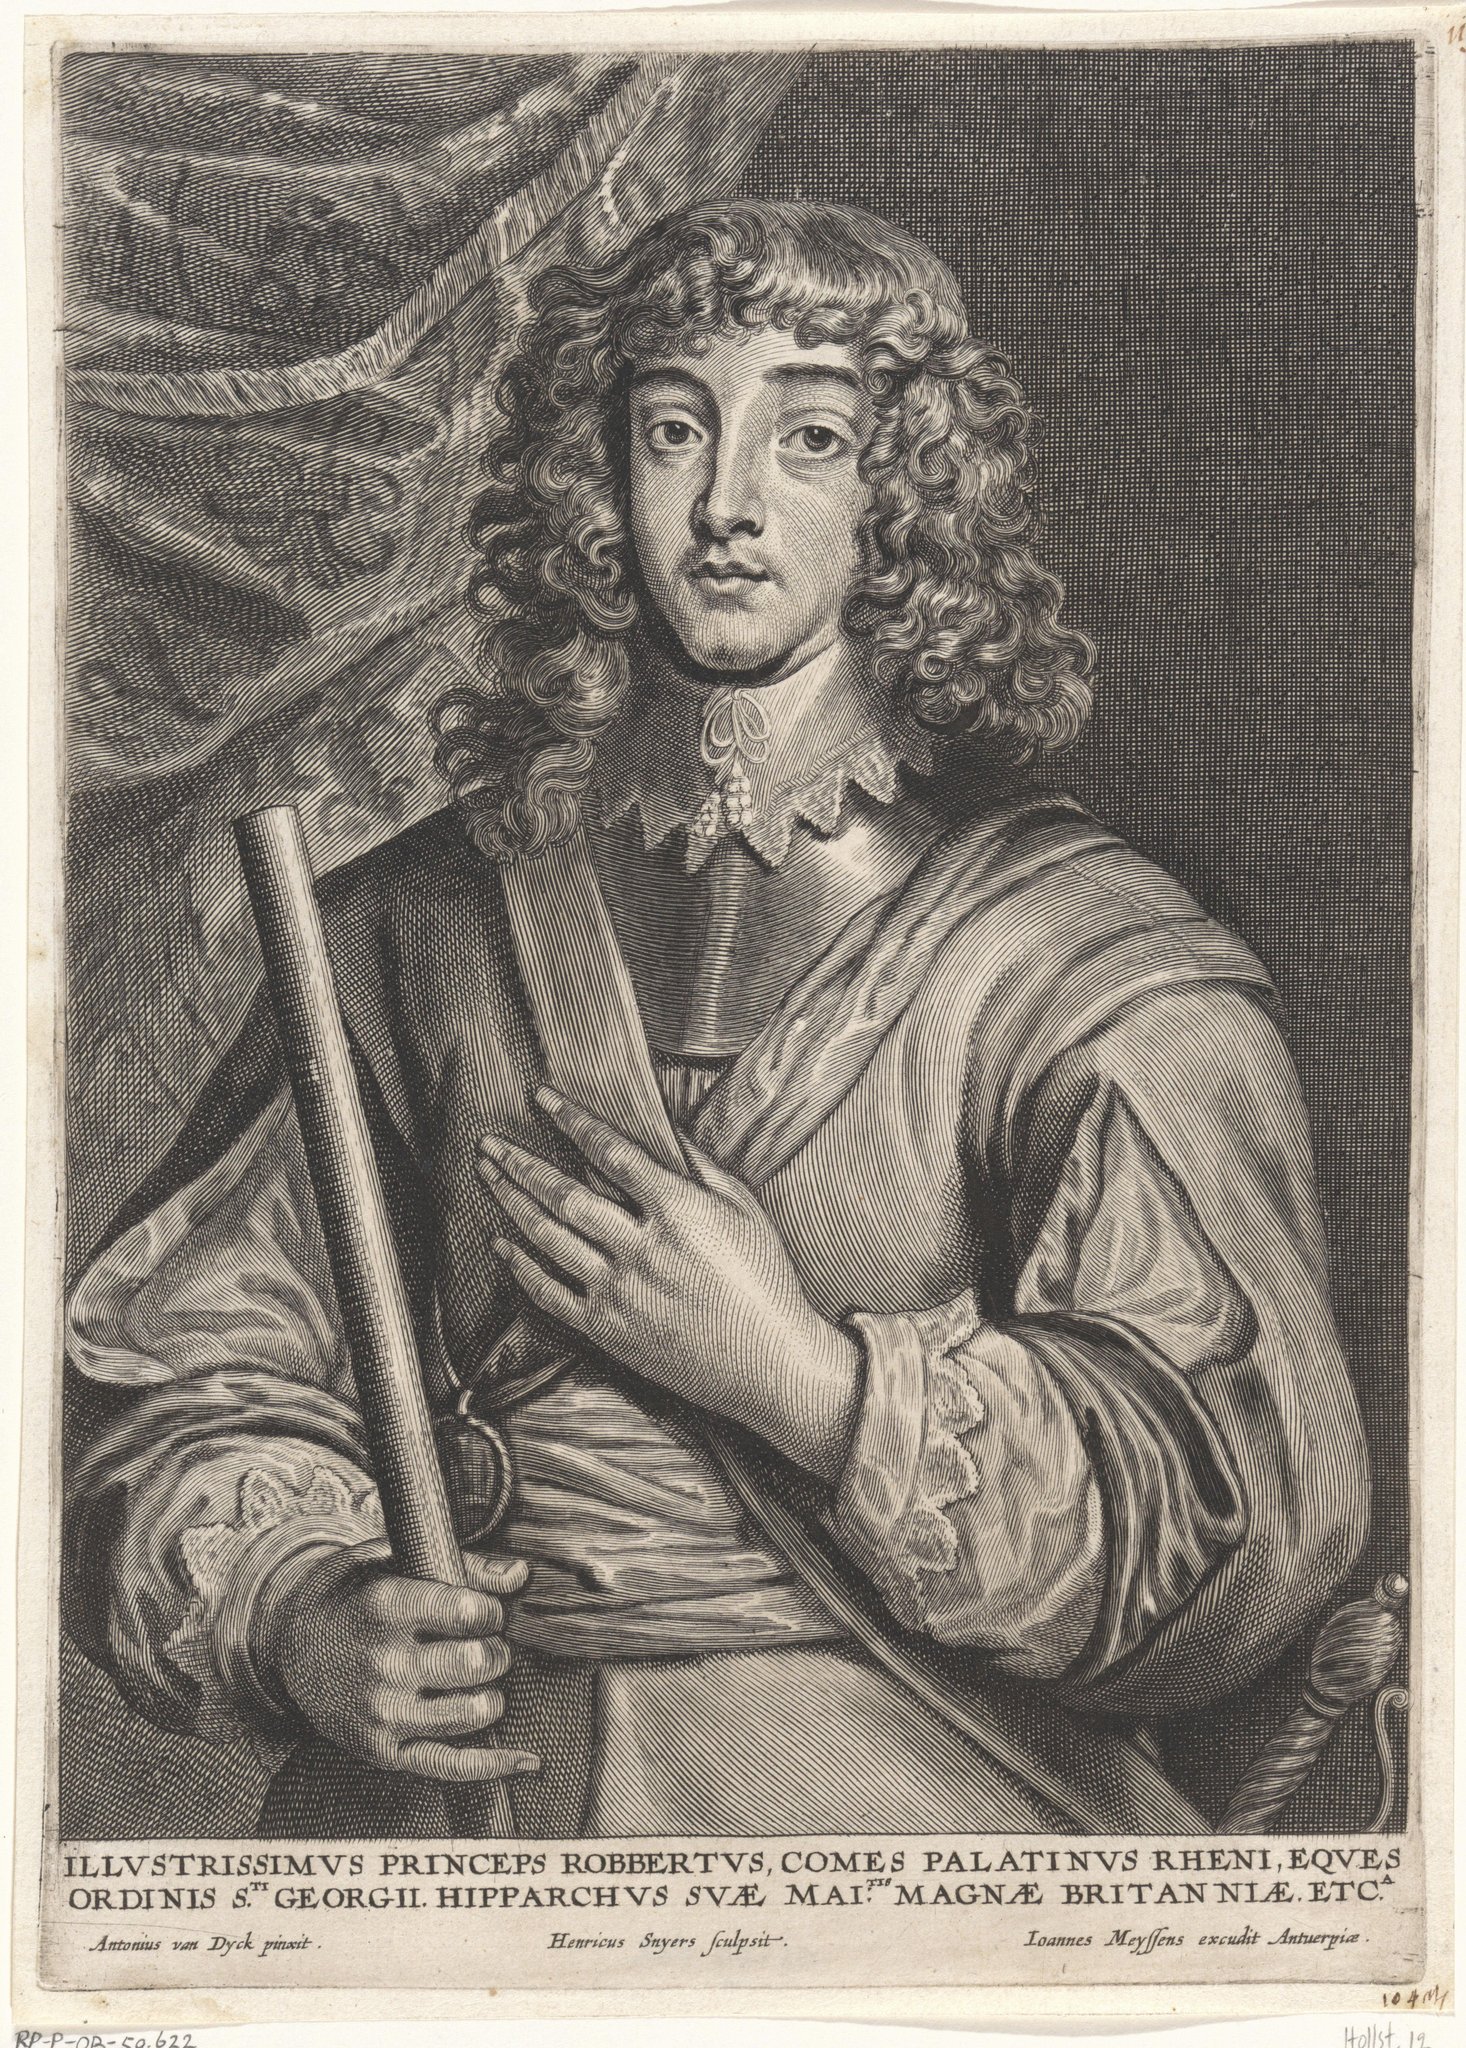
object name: print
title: Illustrissimus princeps Robbertus, comes Palatinus Rheni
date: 1640-1670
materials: paper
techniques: engraving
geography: antwerp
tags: prague, london, painter, print maker, draughtsman, prinz ruprecht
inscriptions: collector's mark: Lugt 240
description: Portret van Prins Ruprecht van de Palts, neef van koning Karel I van Engeland en commandant van de royalistische cavalerie tijdens de Engelse Burgeroorlog. Daarnaast was hij uitvinder en prentmaker.